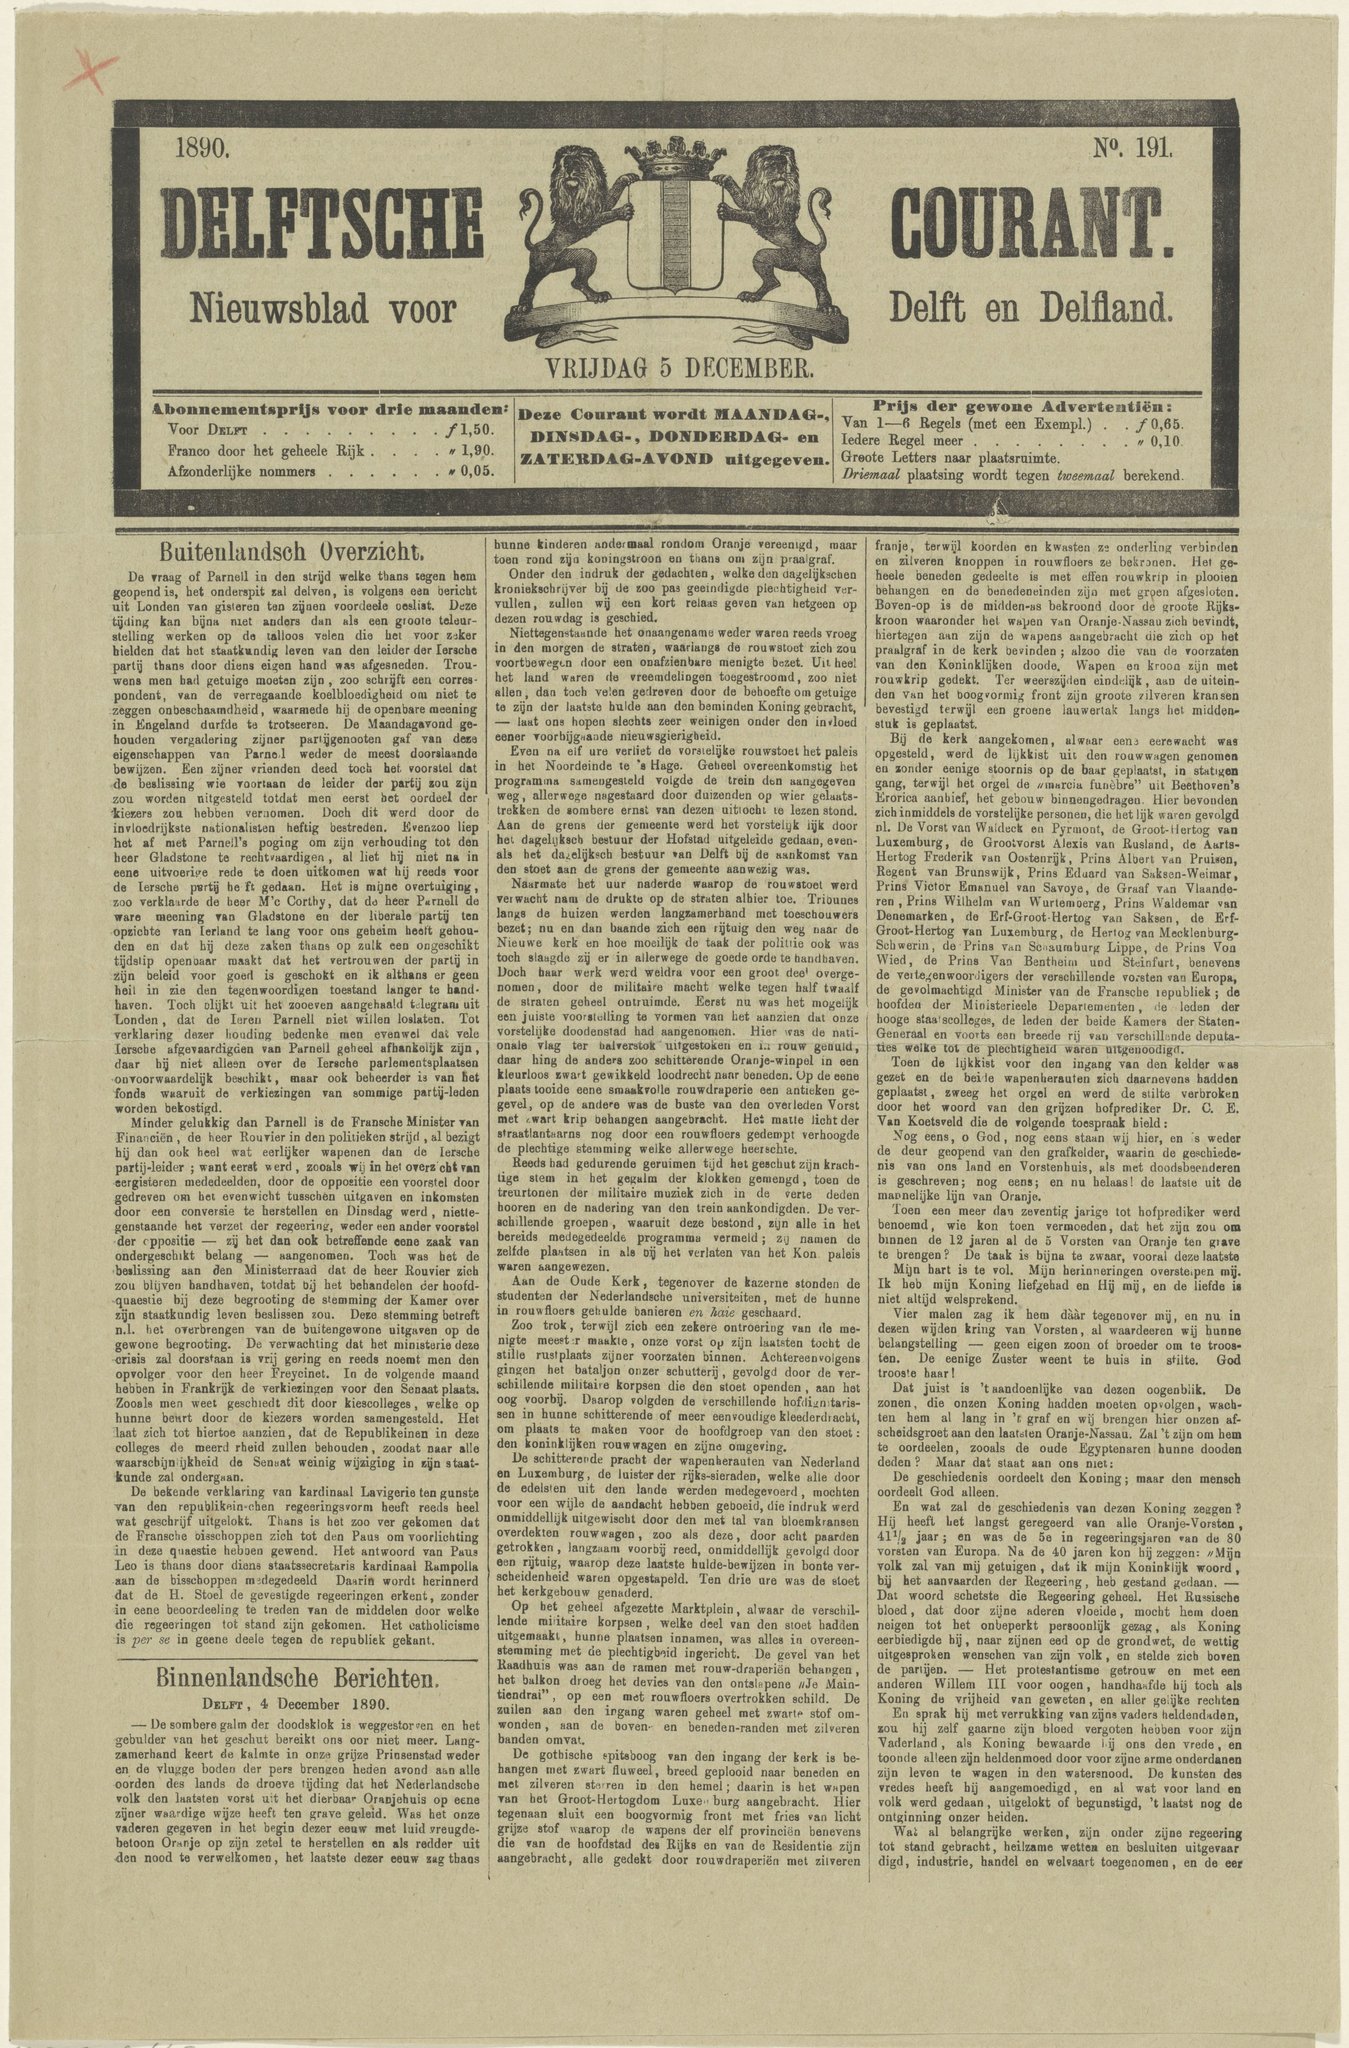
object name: newspaper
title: Krant met een artikel over de begrafenis van Willem III, koning der Nederlanden, op 4 december 1890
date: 1890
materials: paper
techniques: letterpress printing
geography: delft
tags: willem iii (koning der nederlanden), funerary ceremonial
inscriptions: date